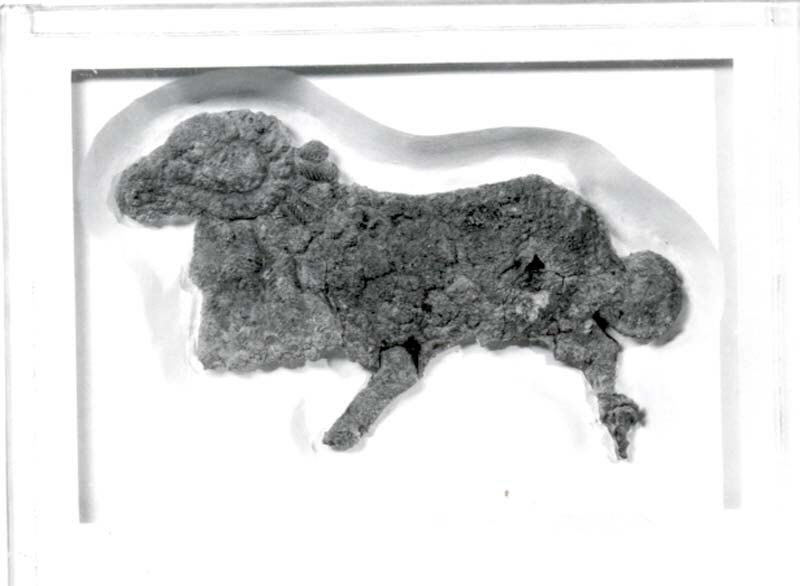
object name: relief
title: Plaque with ram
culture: assyrian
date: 800-601 BCE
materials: bronze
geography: mesopotamia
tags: rams